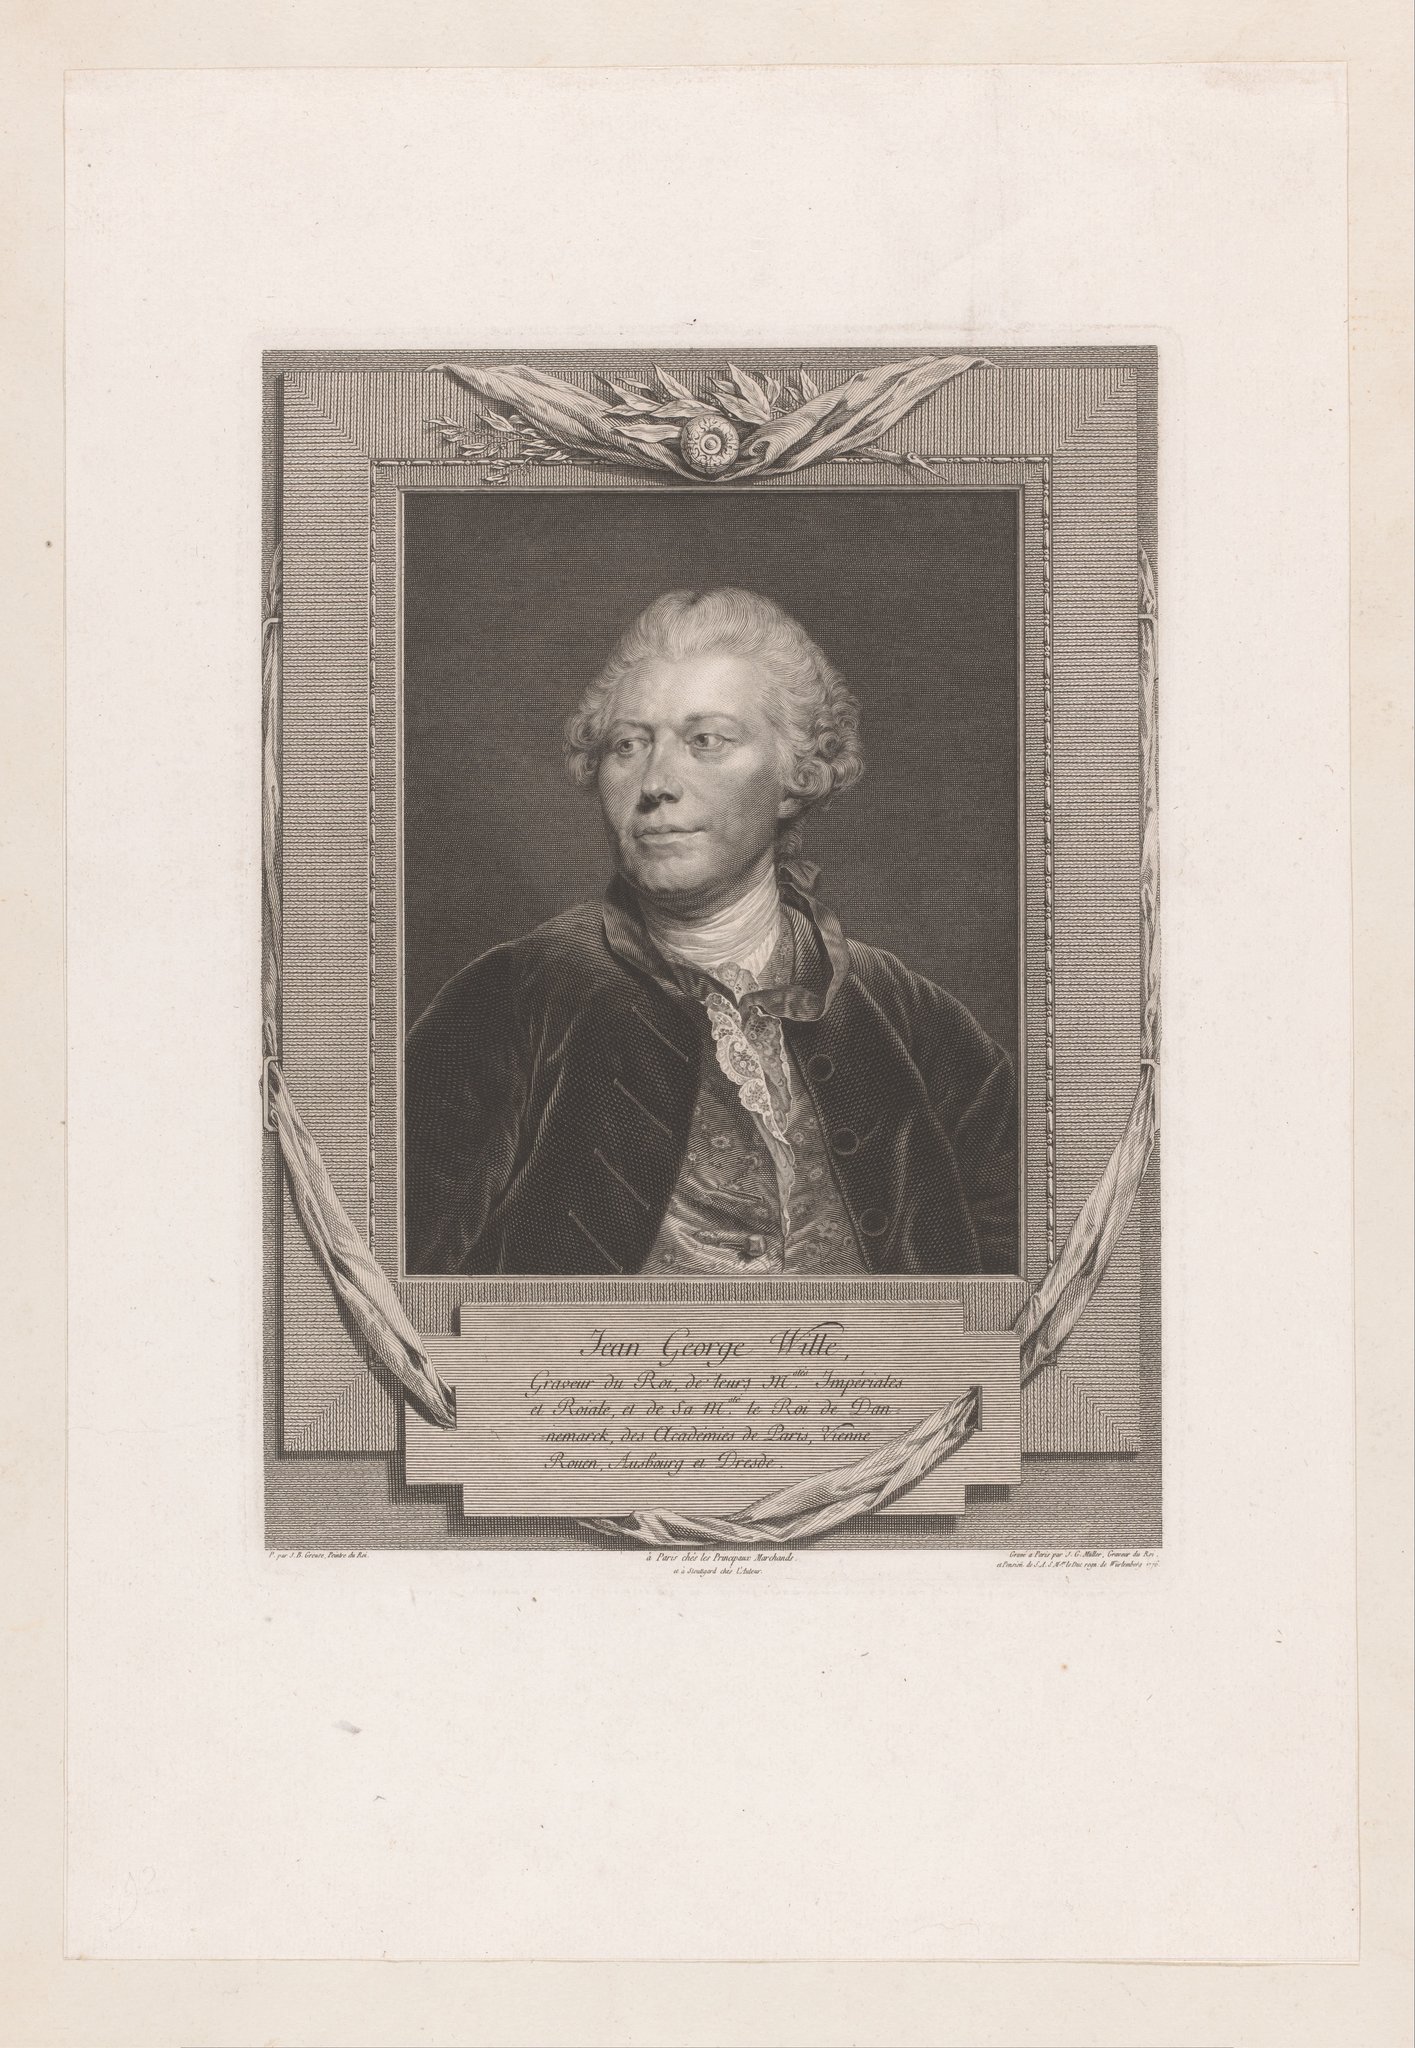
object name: print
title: Portret van Johann Georg Wille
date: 1757-1830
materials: paper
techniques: engraving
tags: paris, print maker, draughtsman, johann georg wille, historical persons